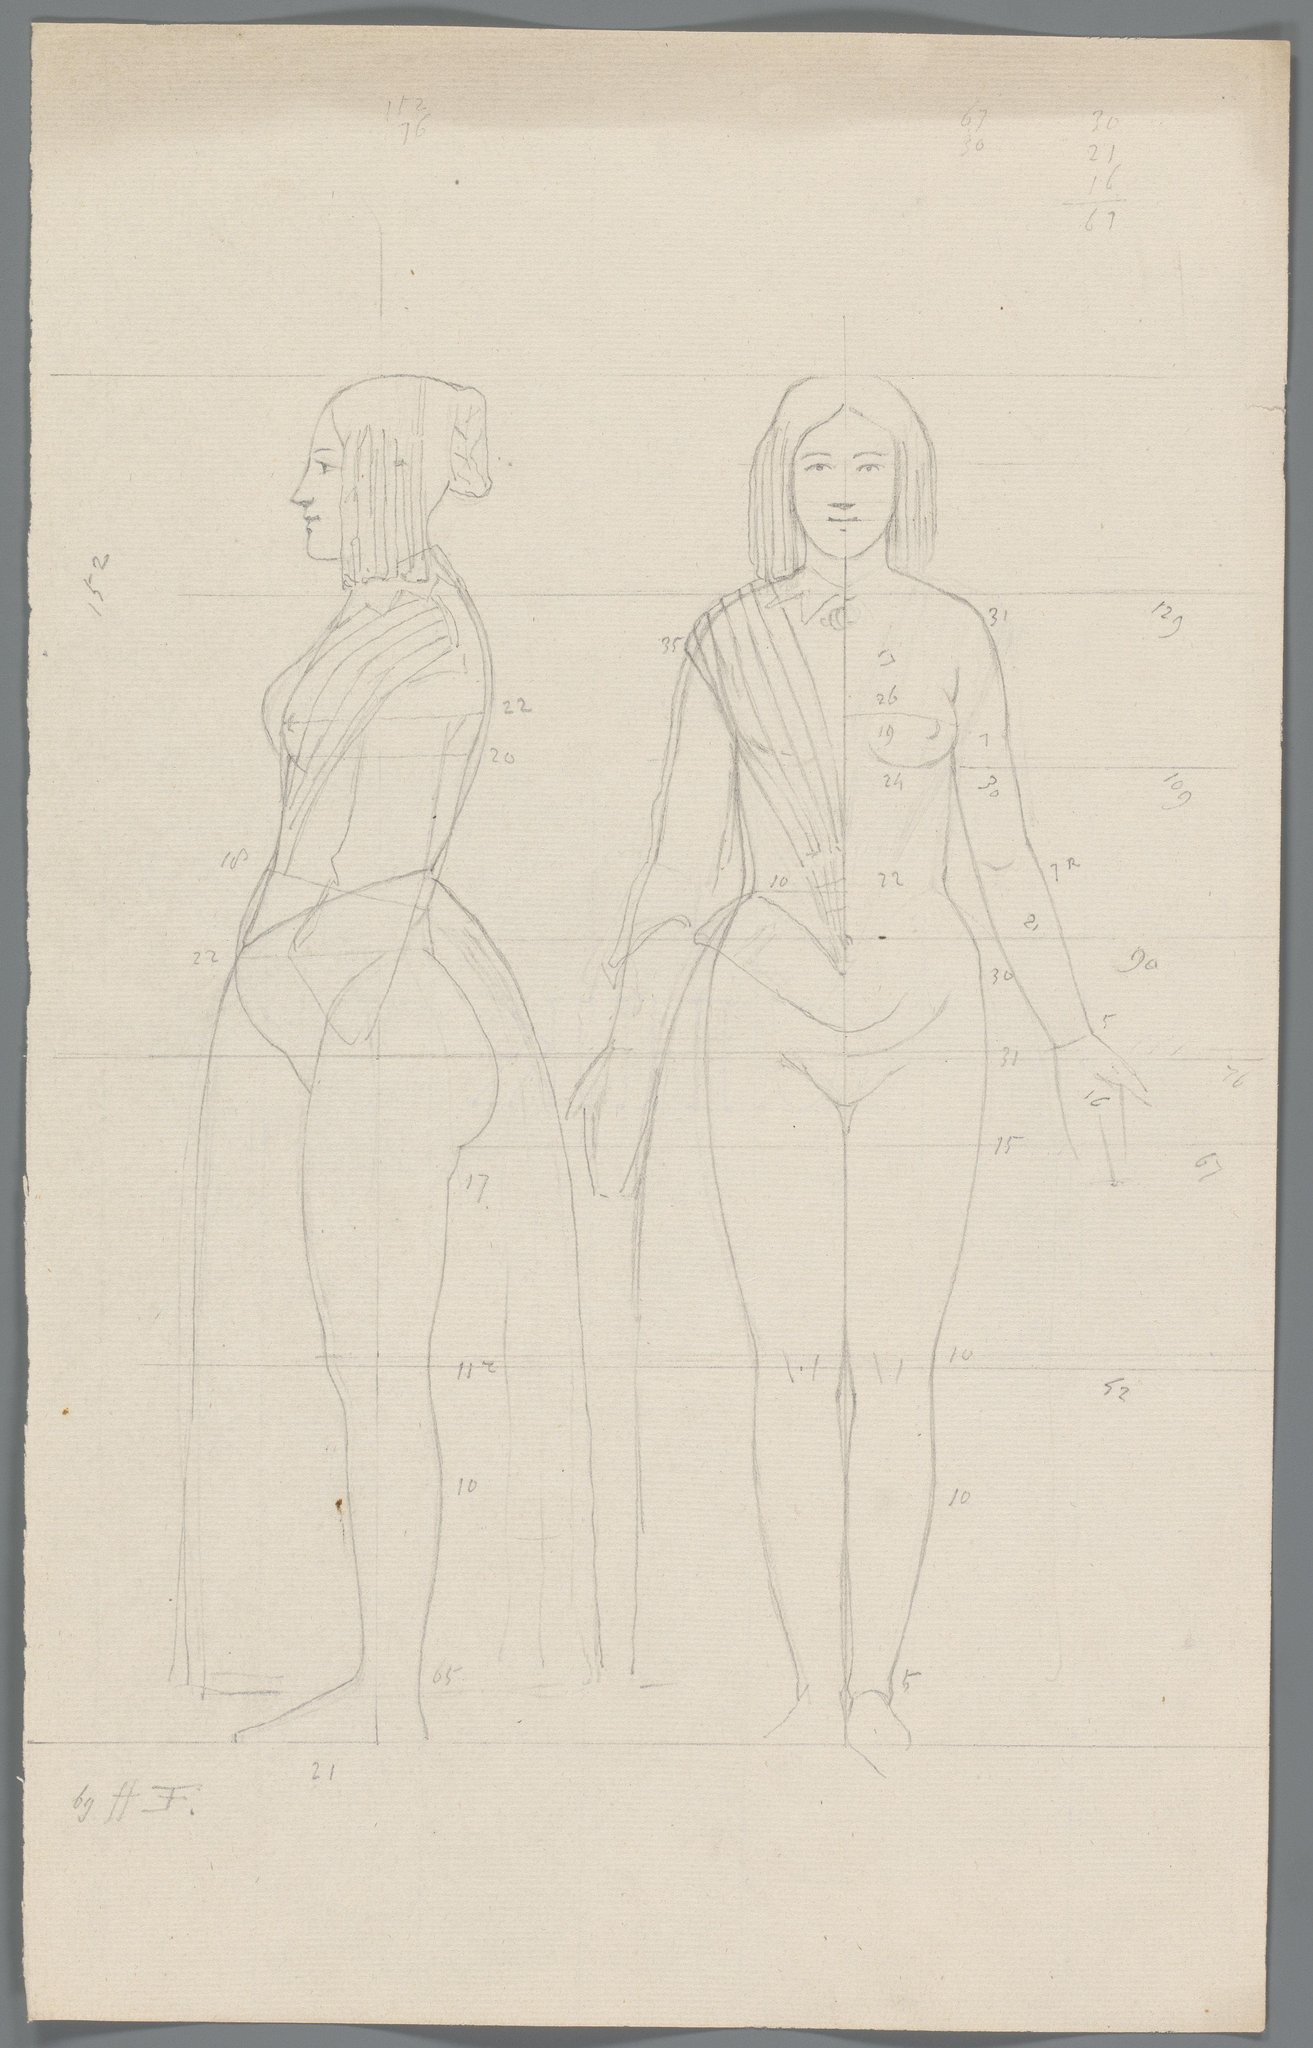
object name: drawing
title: Proportiestudie van een vrouw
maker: jacobus everhardus josephus van den berg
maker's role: draughtsman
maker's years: 1802-1861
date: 1856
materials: paper, pencil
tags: standing figure (canon, proportions) - aa - female human figure, anatomy (non-medical) - aa - female human figure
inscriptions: inscription: ‘bg ff EF’